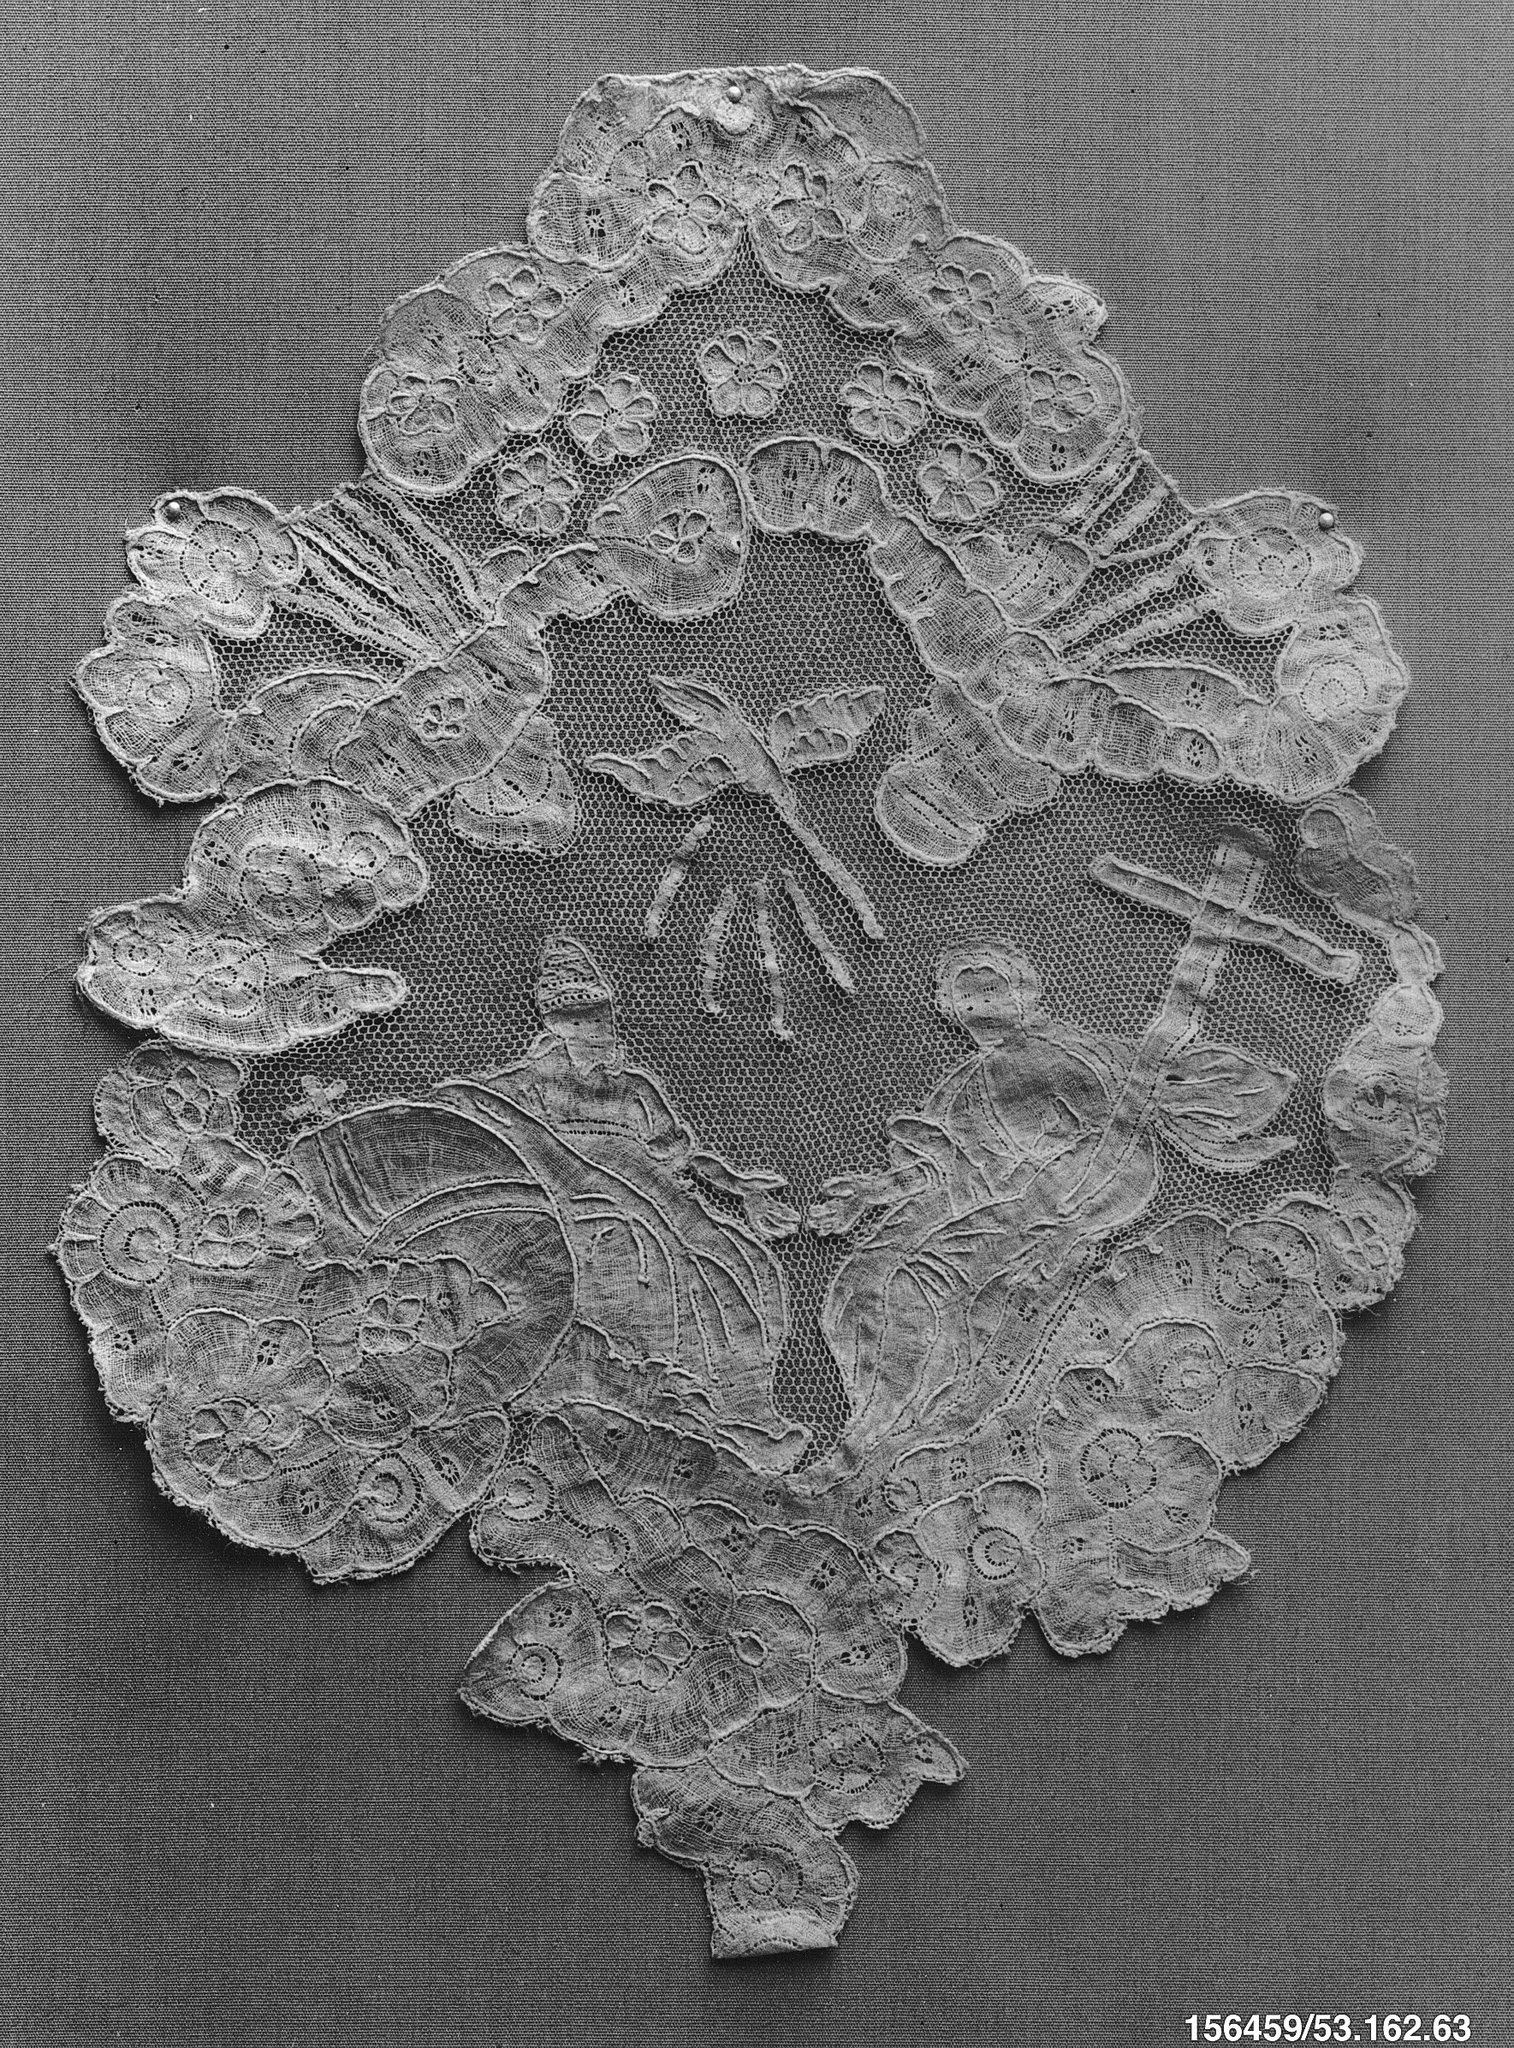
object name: piece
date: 1701-1800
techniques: lace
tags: human figures,birds,flowers,cross